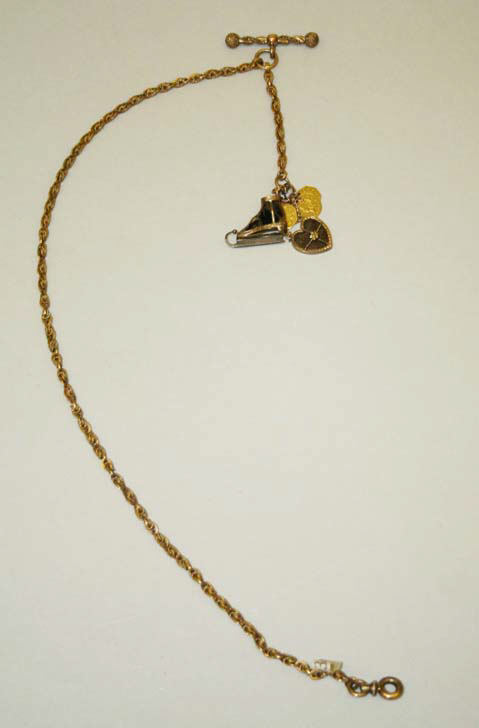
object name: fob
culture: american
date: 1870